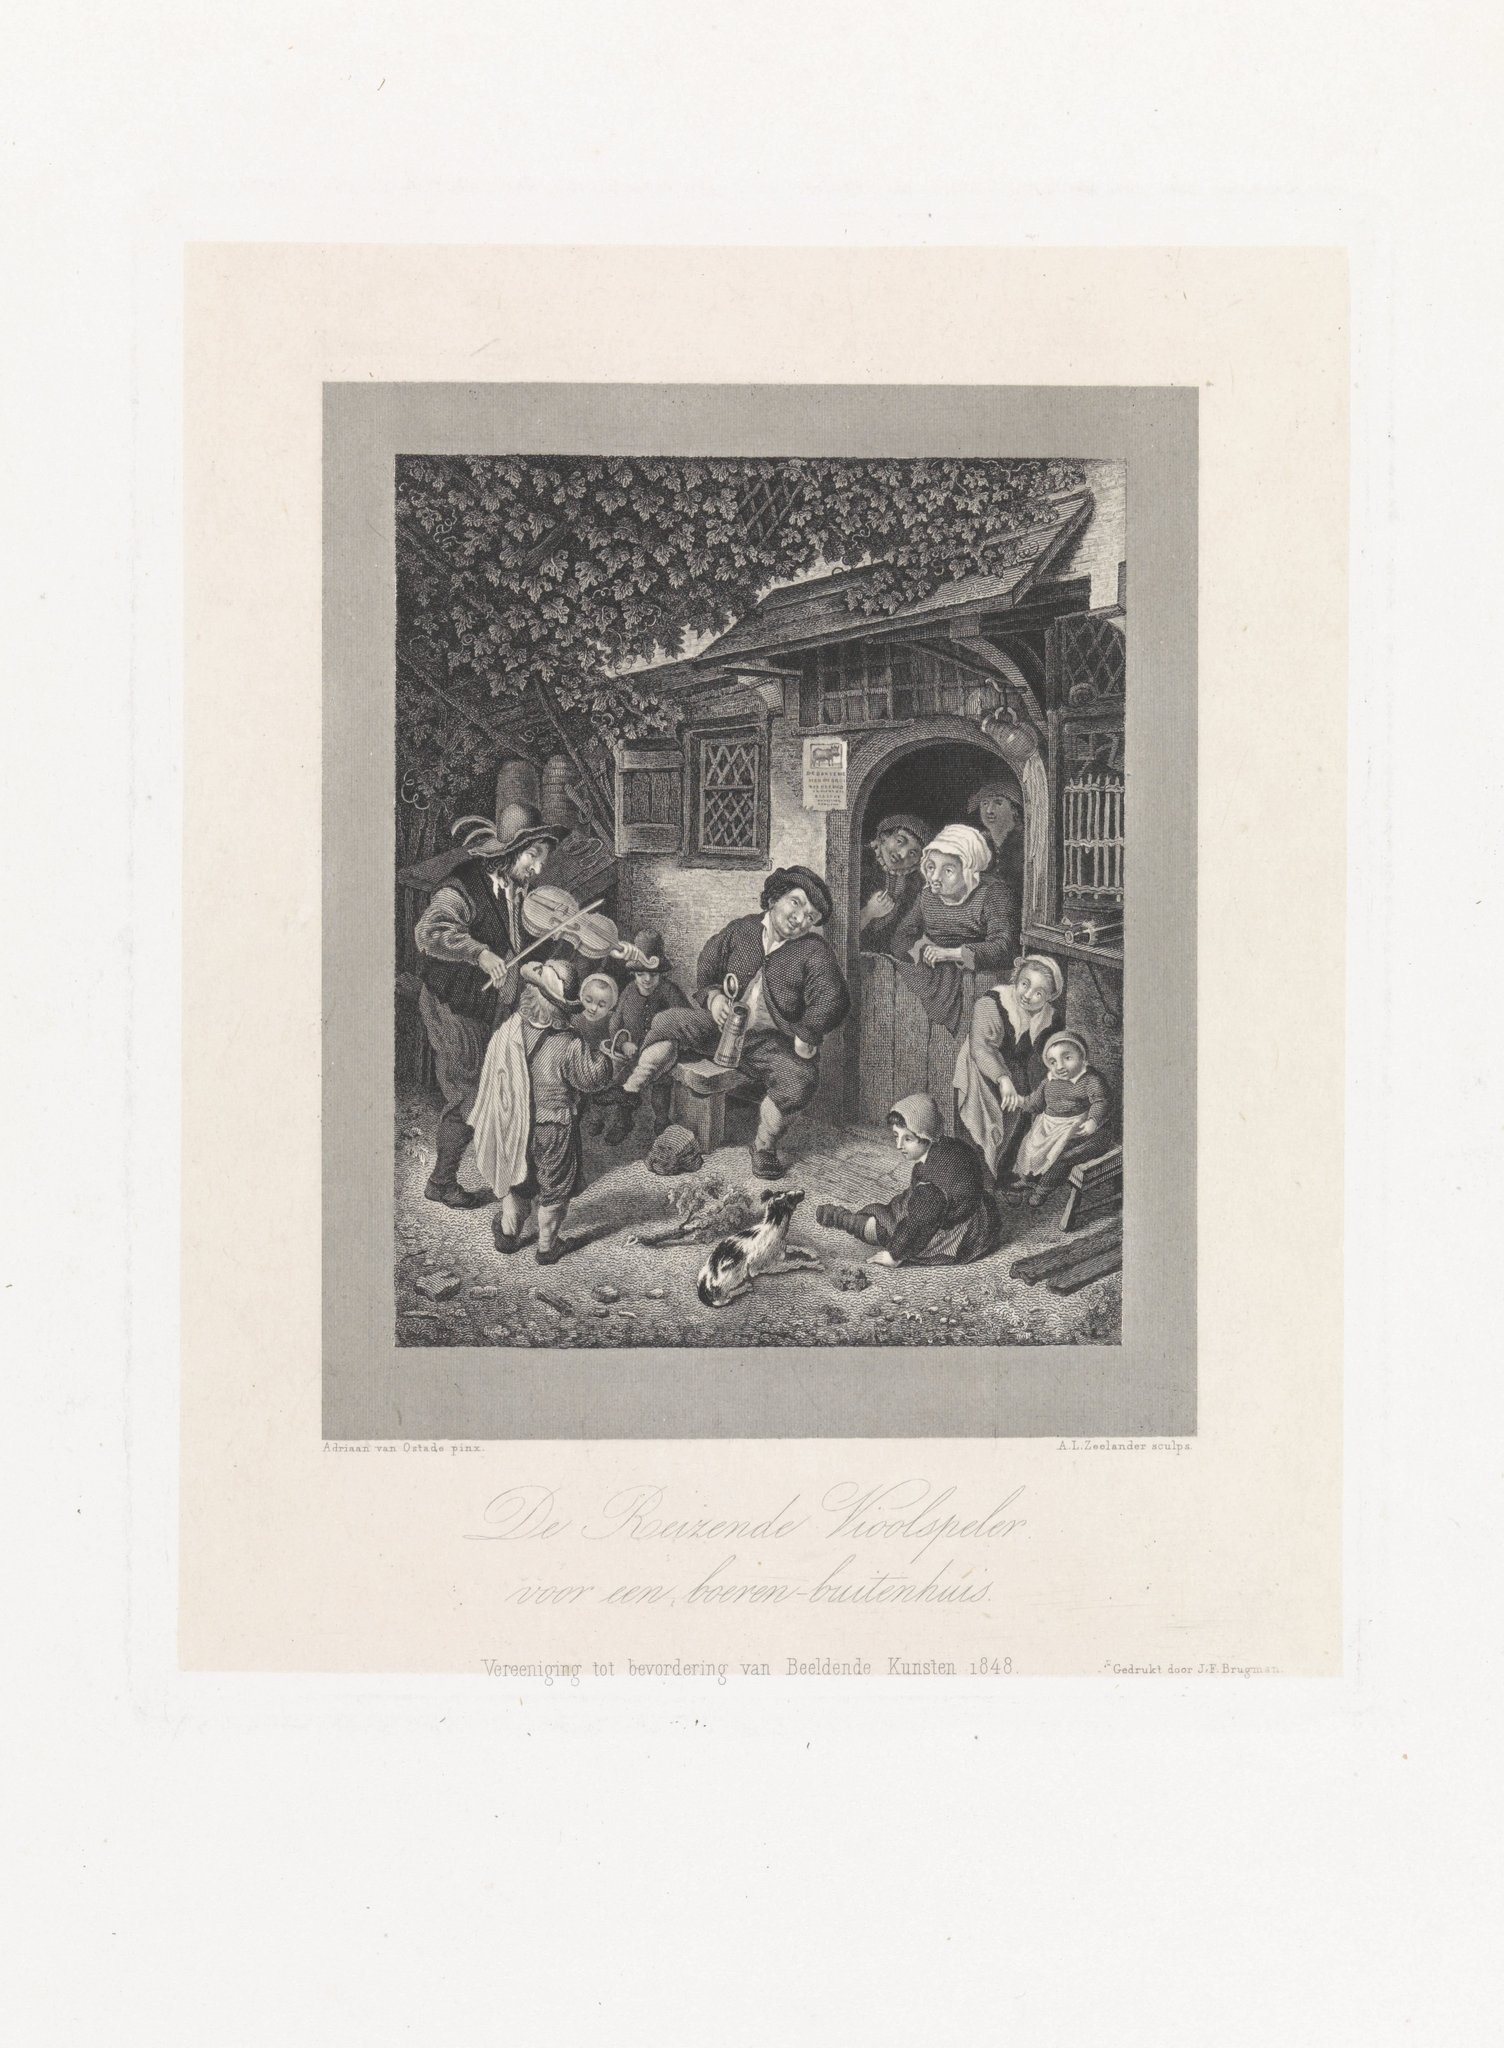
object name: print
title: Vioolspeler voor een herberg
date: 1848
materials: paper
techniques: engraving, etching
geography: amsterdam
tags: one person playing string instrument (bowed), inn, coffee-house, public house, etc., dog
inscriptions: collector's mark: Lugt 2228, collector's mark: Lugt 2760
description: Een man met viool en een jongen met draailier maken muziek bij een herberg. Volwassenen en kinderen luisteren. Een vrouw leunt over de onderdeur.